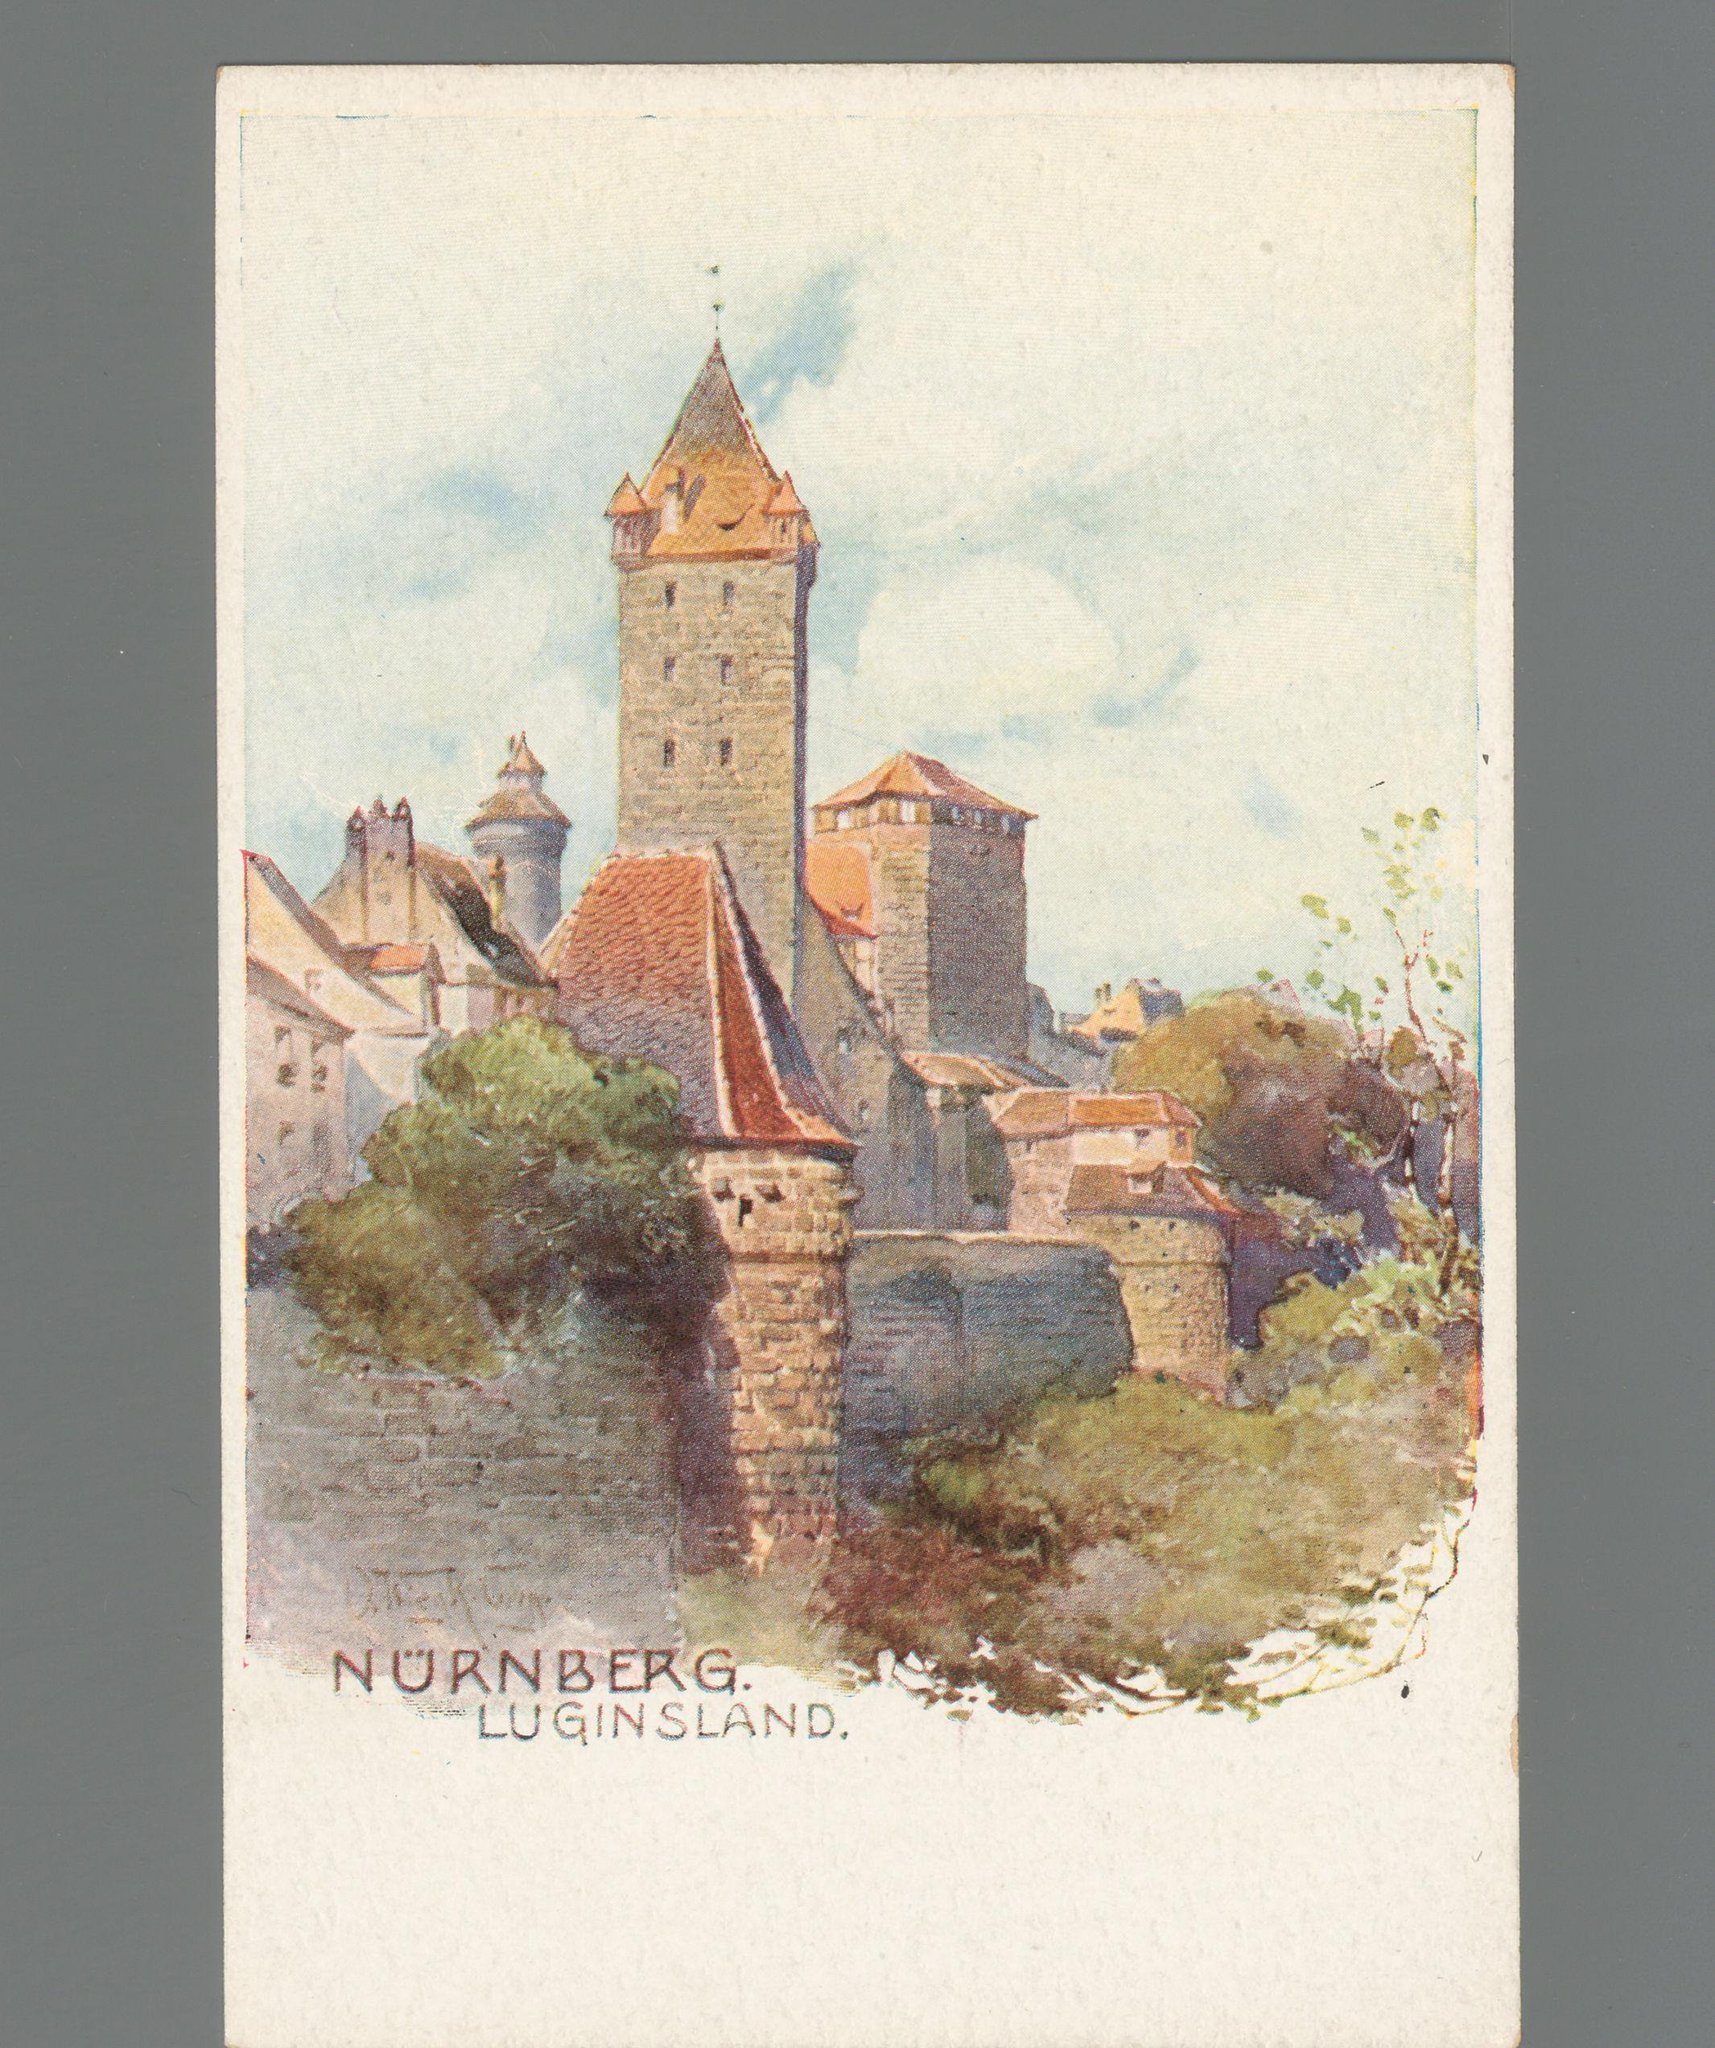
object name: ansichtkaart, prentbriefkaart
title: Nürnberg. Luginsland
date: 1905-1930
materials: cardboard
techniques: color autotype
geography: nuremberg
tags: castle, towers ~ fortified city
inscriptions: inscription: ‘J Wien K’